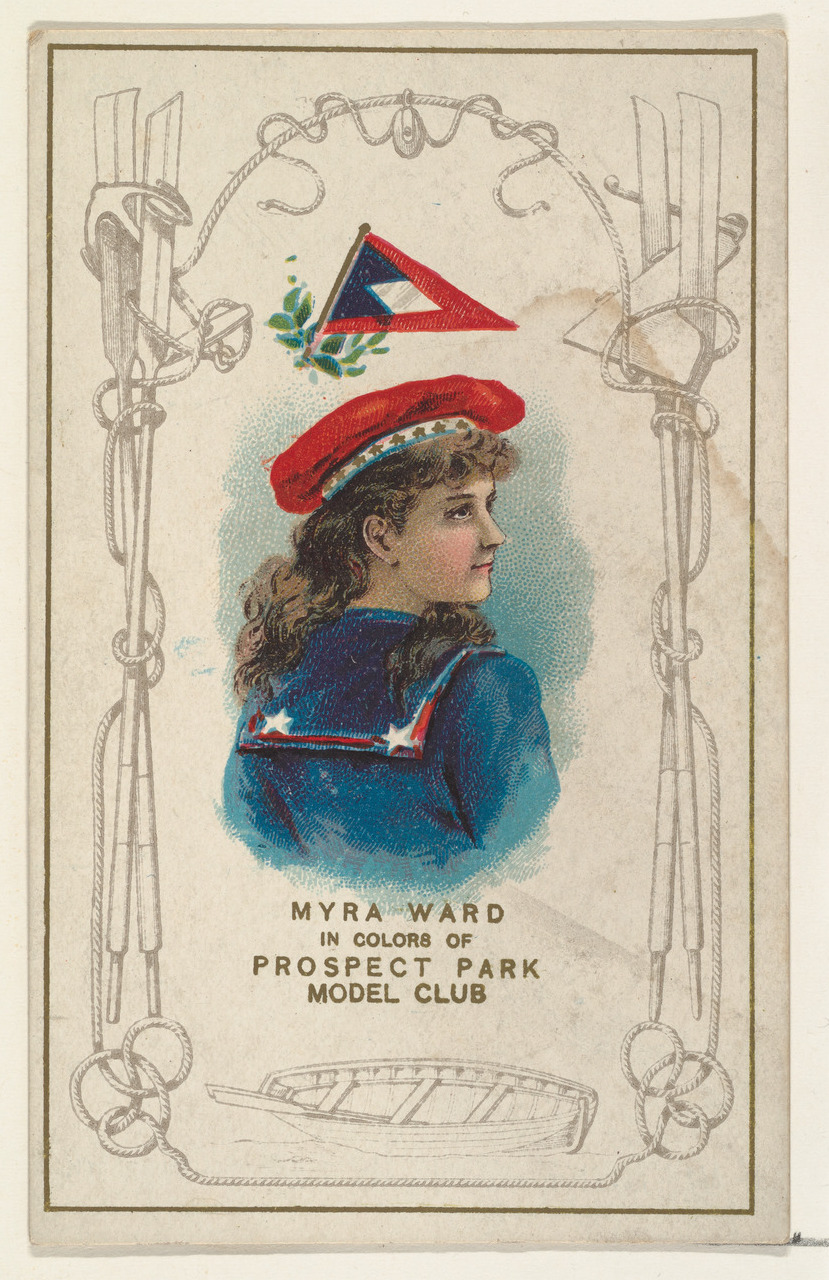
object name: print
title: Myra Ward in Colors of Prospect Park Model Club, from the Yacht Colors of the World series (N140) issued by Duke Sons & Co. to promote Honest Long Cut Tobacco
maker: w. duke, sons & co.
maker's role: publisher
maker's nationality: american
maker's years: 1870-1920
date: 1890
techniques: color lithograph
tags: profiles,women,boats